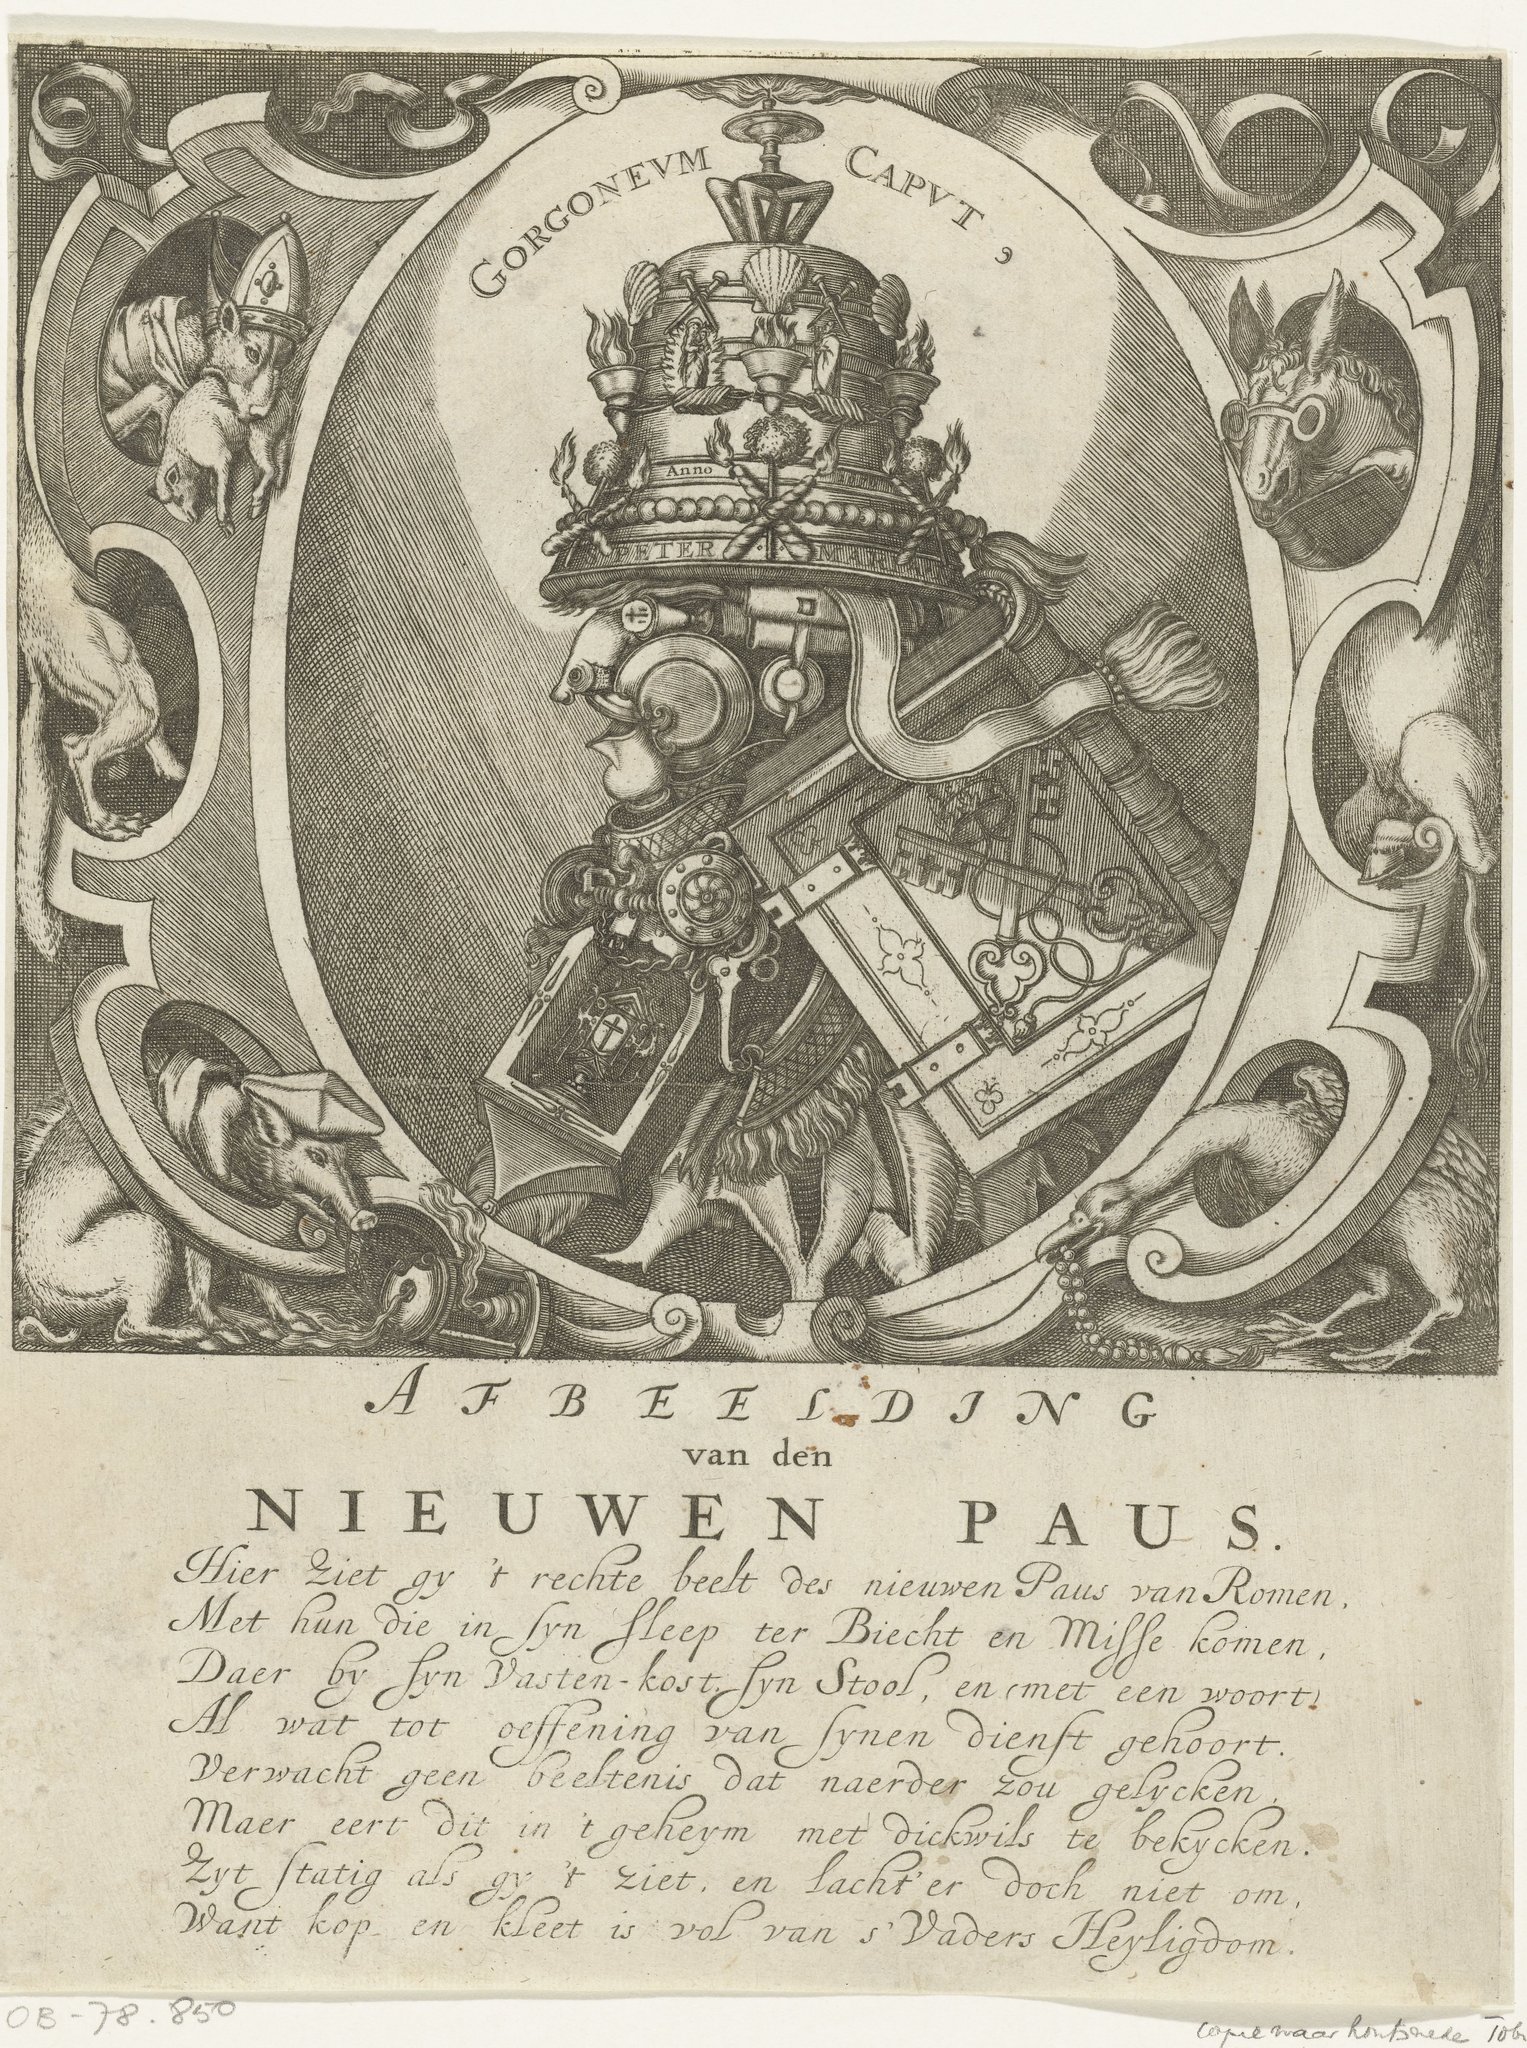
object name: print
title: Afbeelding van den Nieuwen Paus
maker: Anonymous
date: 1670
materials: paper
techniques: engraving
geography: low countries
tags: clemens x, reformation (roman catholic church vs. protestantism), pope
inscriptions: date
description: Grotesk portret van de nieuwe paus. Hoofd van de paus op de manier van Arcimboldo opgebouwd uit allerlei objecten die gerelateerd zijn aan de katholieke kerk. Vervaardigd naar aanleiding van de verkiezing van de nieuwe paus Clemens X in 1670. In het rolwerk om het portret een wolf met een schaap in de bek, een varken met een wierookvat, een lezende ezel met bril en een gans met en rozenkrans. Met onderschrift van 8 regels in het Nederlands.